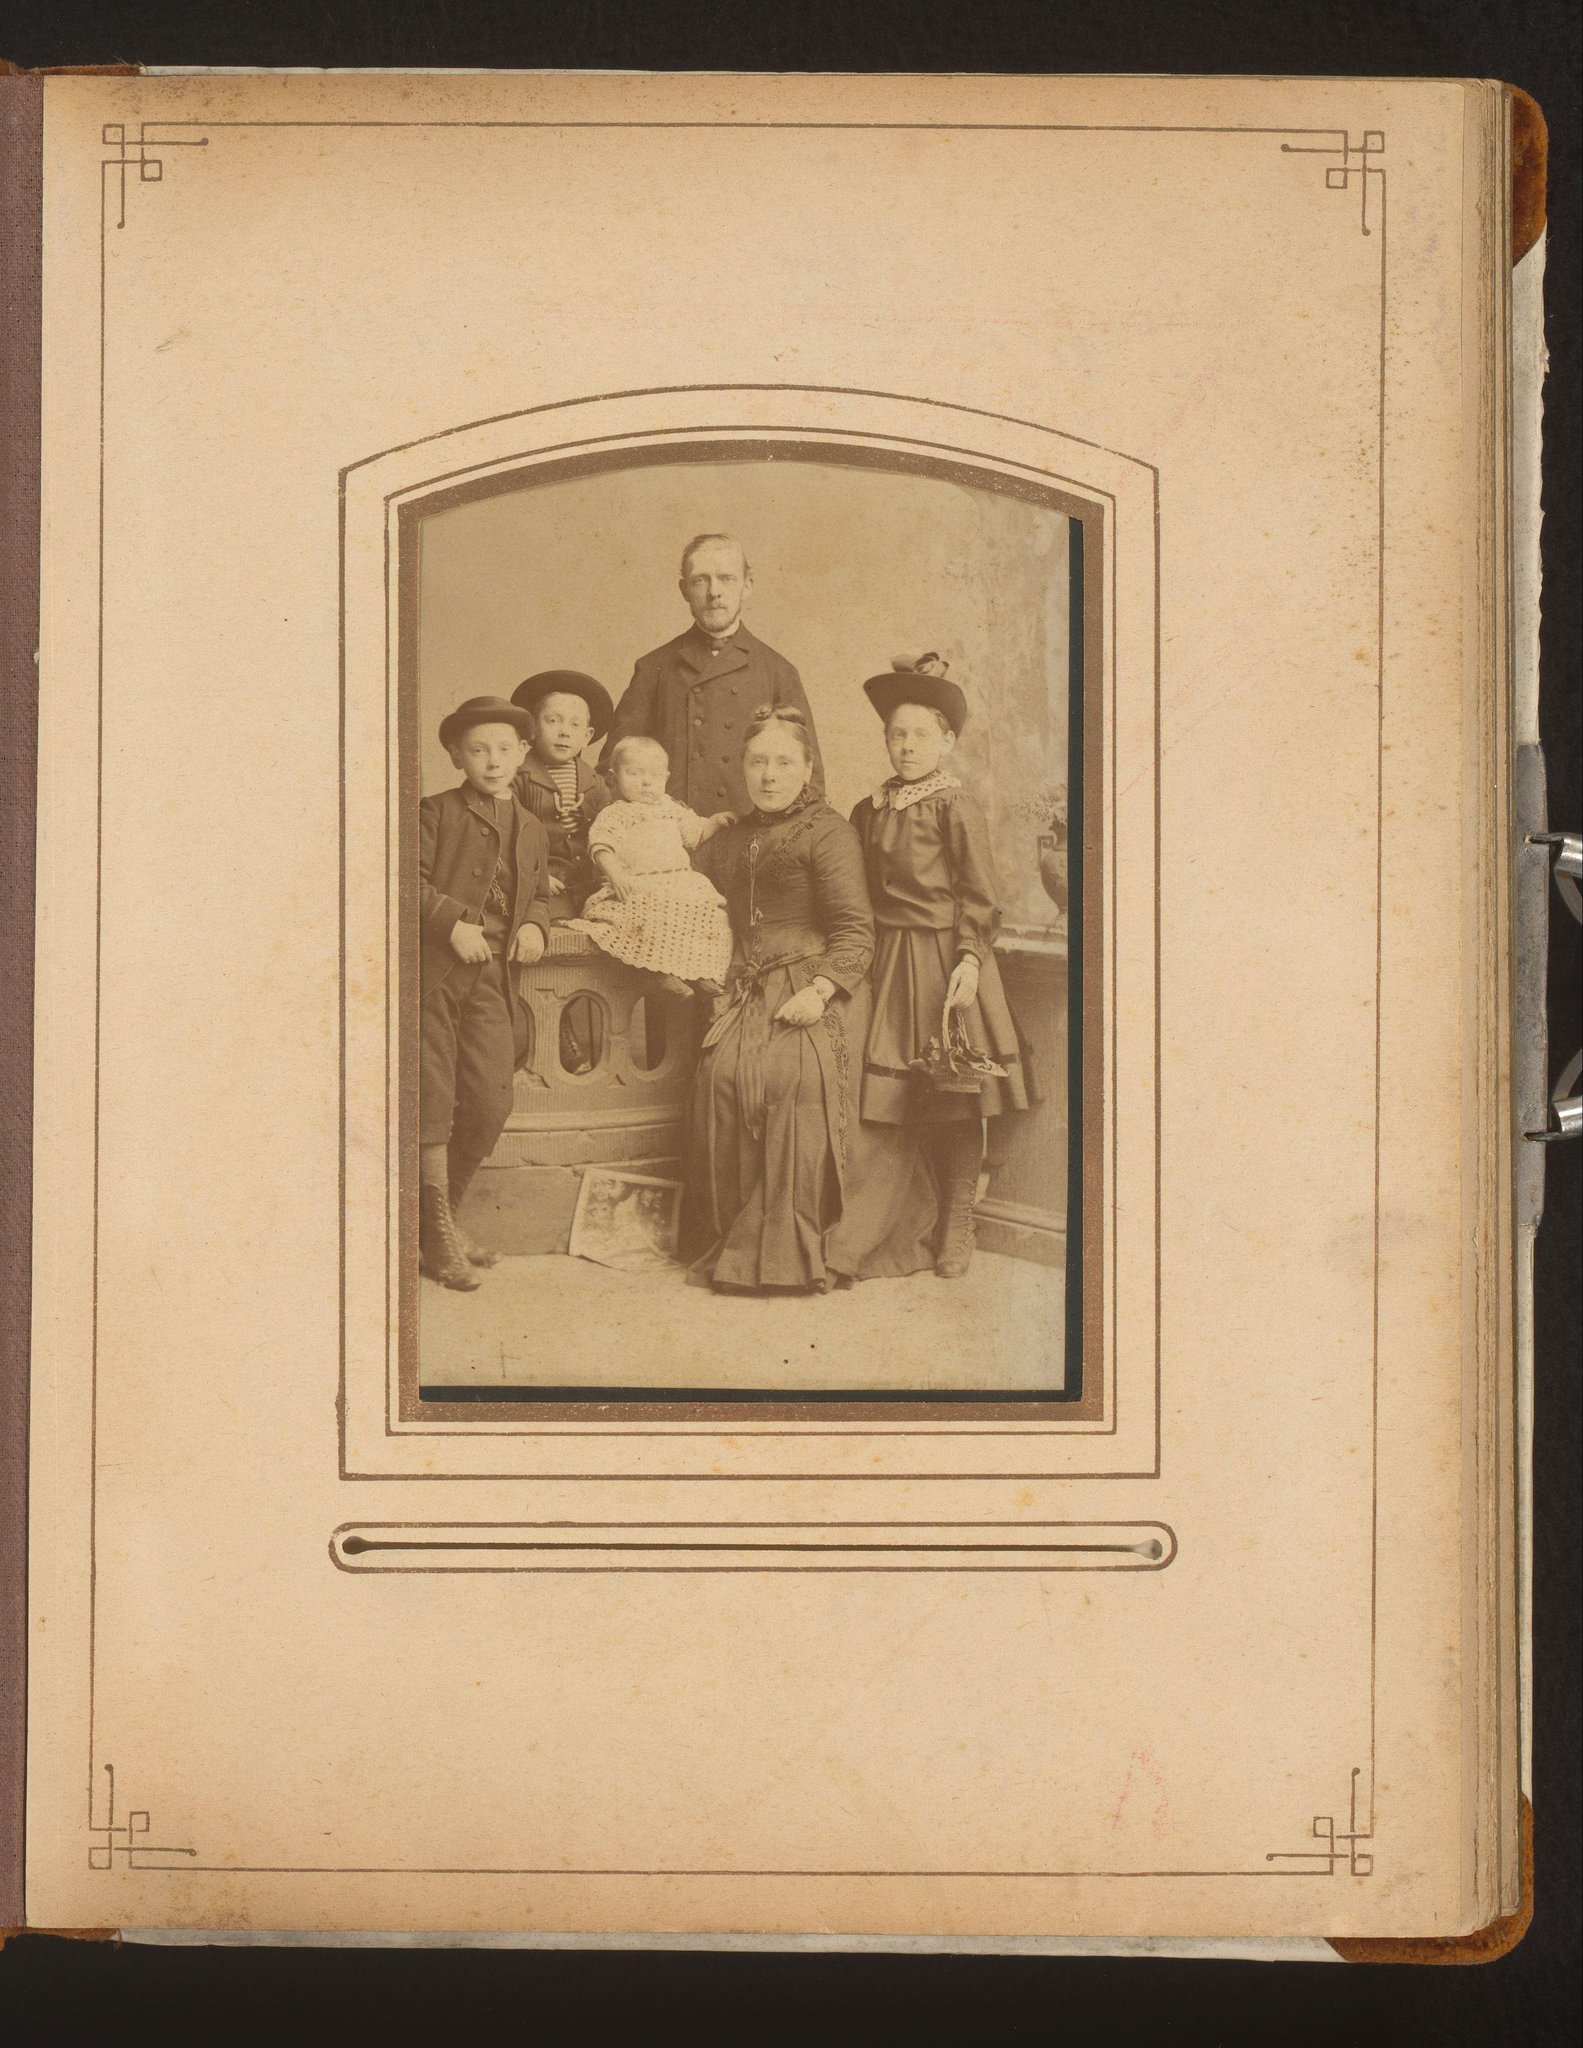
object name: album leaf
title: Familieportret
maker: jan goedeljee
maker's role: fotograaf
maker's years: 1824-1905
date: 1889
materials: cardboard, photographic support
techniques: albumen print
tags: parents with their children, historical persons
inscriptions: date: ‘18 Nov 1889’